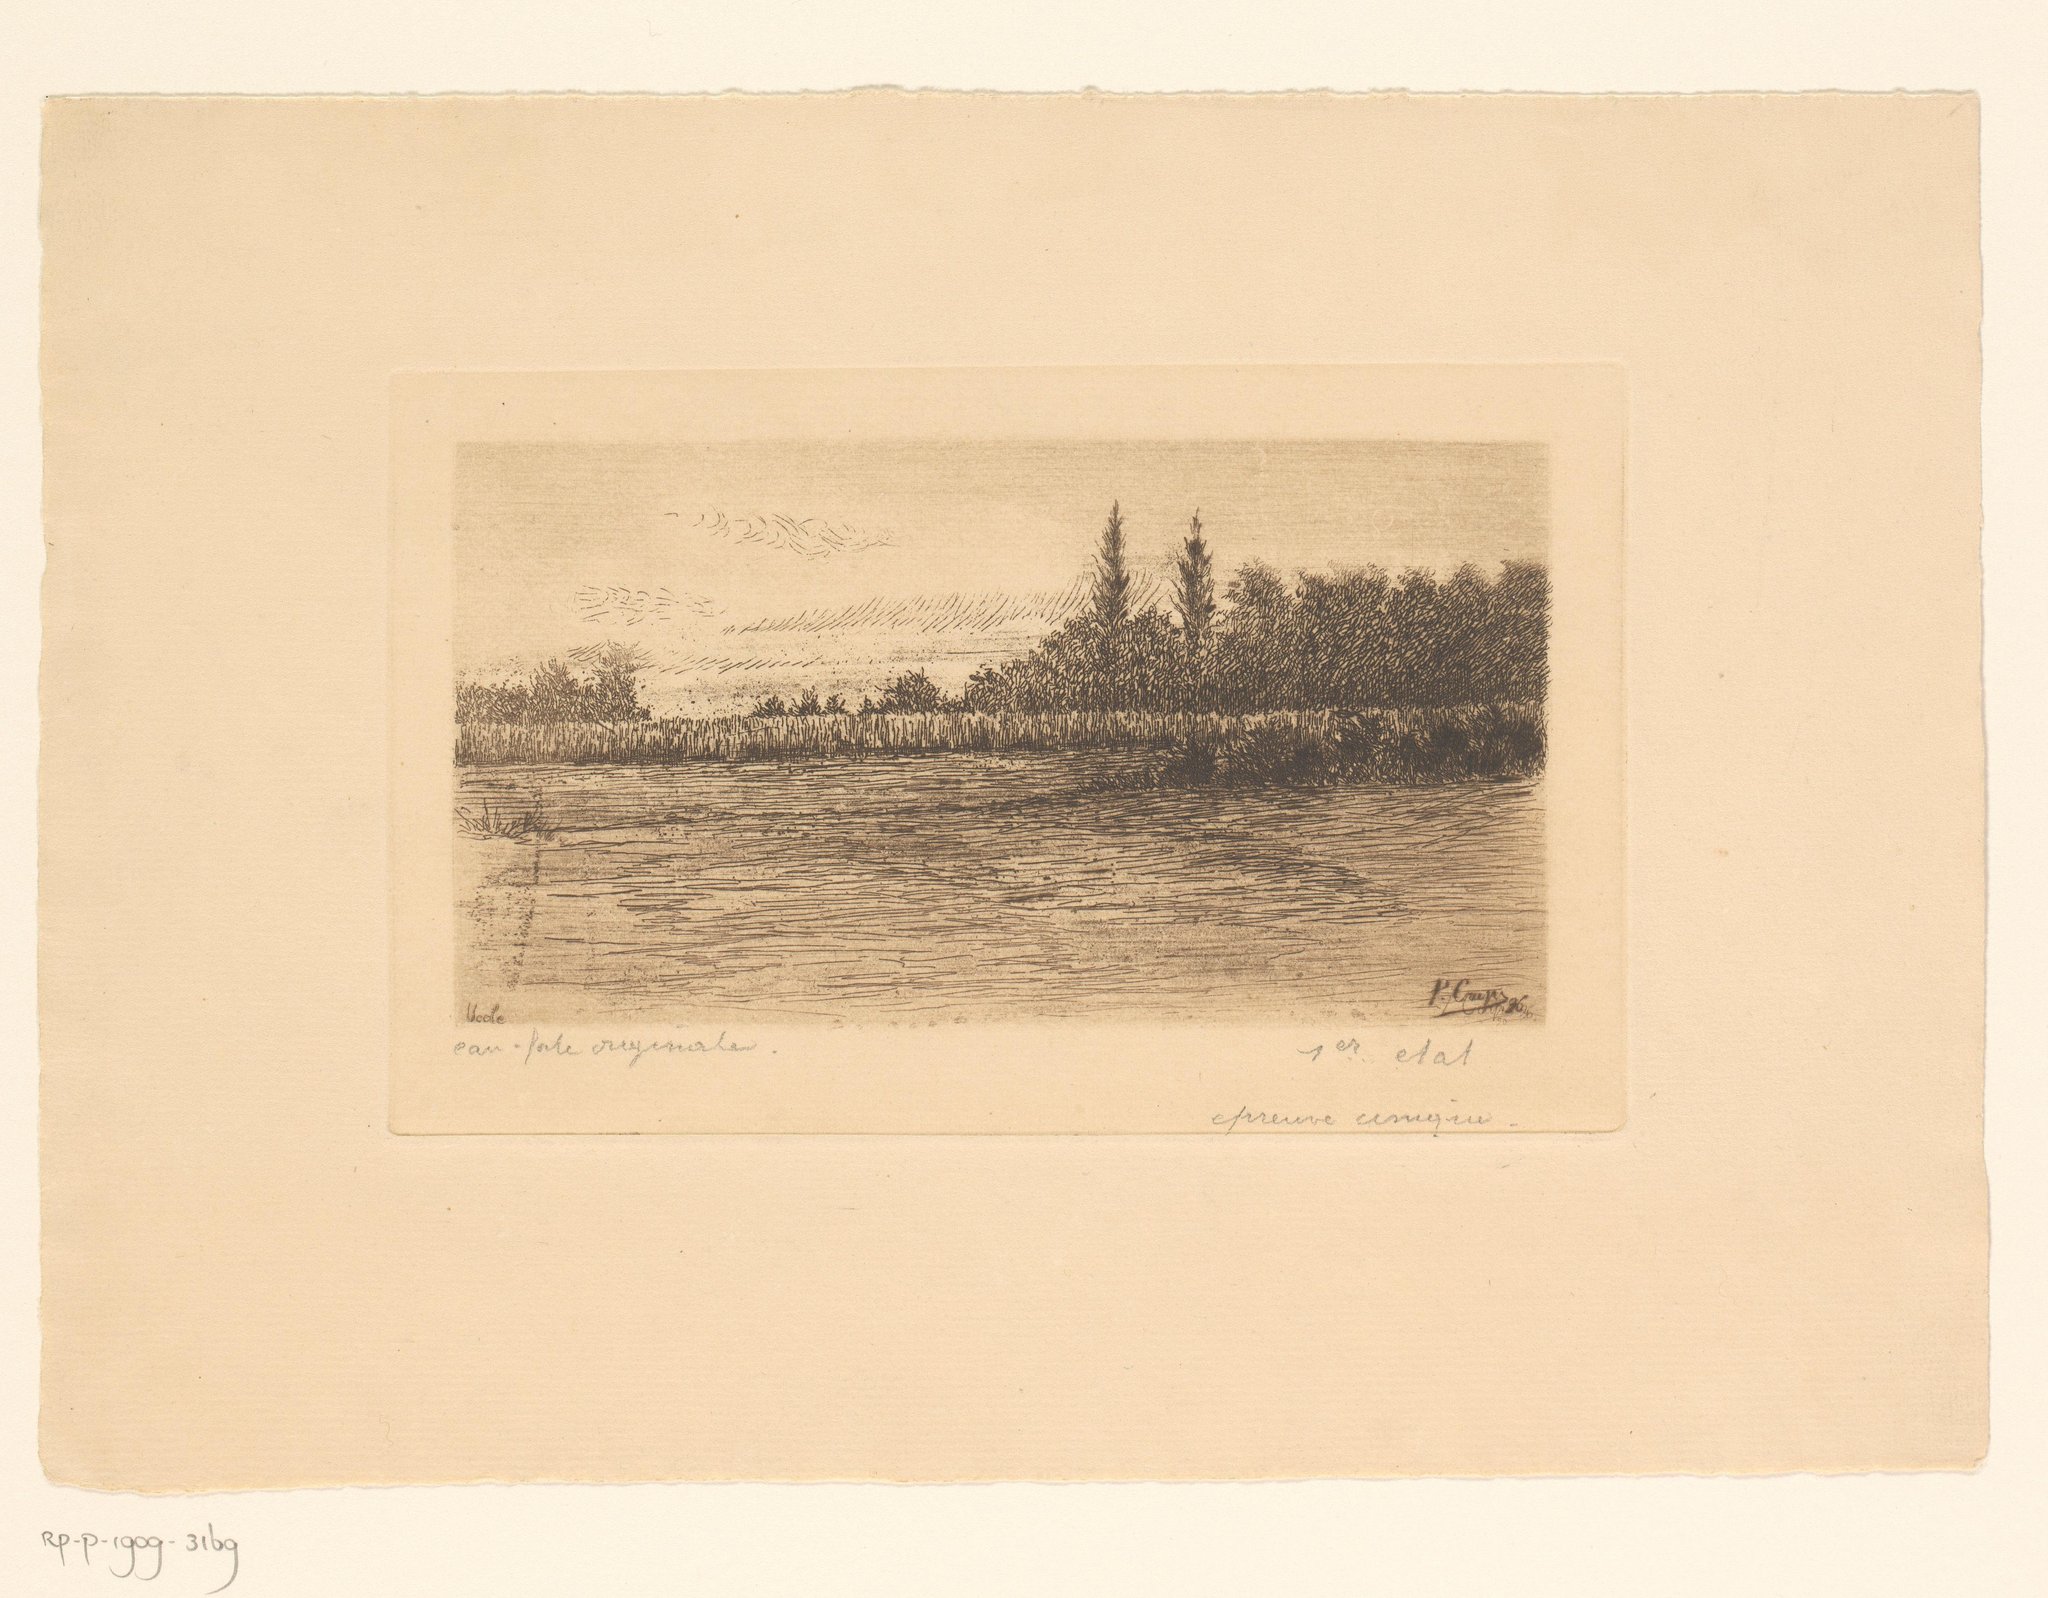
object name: print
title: Uccle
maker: pol craps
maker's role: print maker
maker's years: 1877-1939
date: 1896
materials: paper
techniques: drypoint, etching, intaglio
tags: landscapes in the temperate zone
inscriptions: collector's mark: Lugt 2228, watermark: ‘Van Gelder Zonen’, annotation: ‘eau-forte originale; 1er etat; epreuve unique’